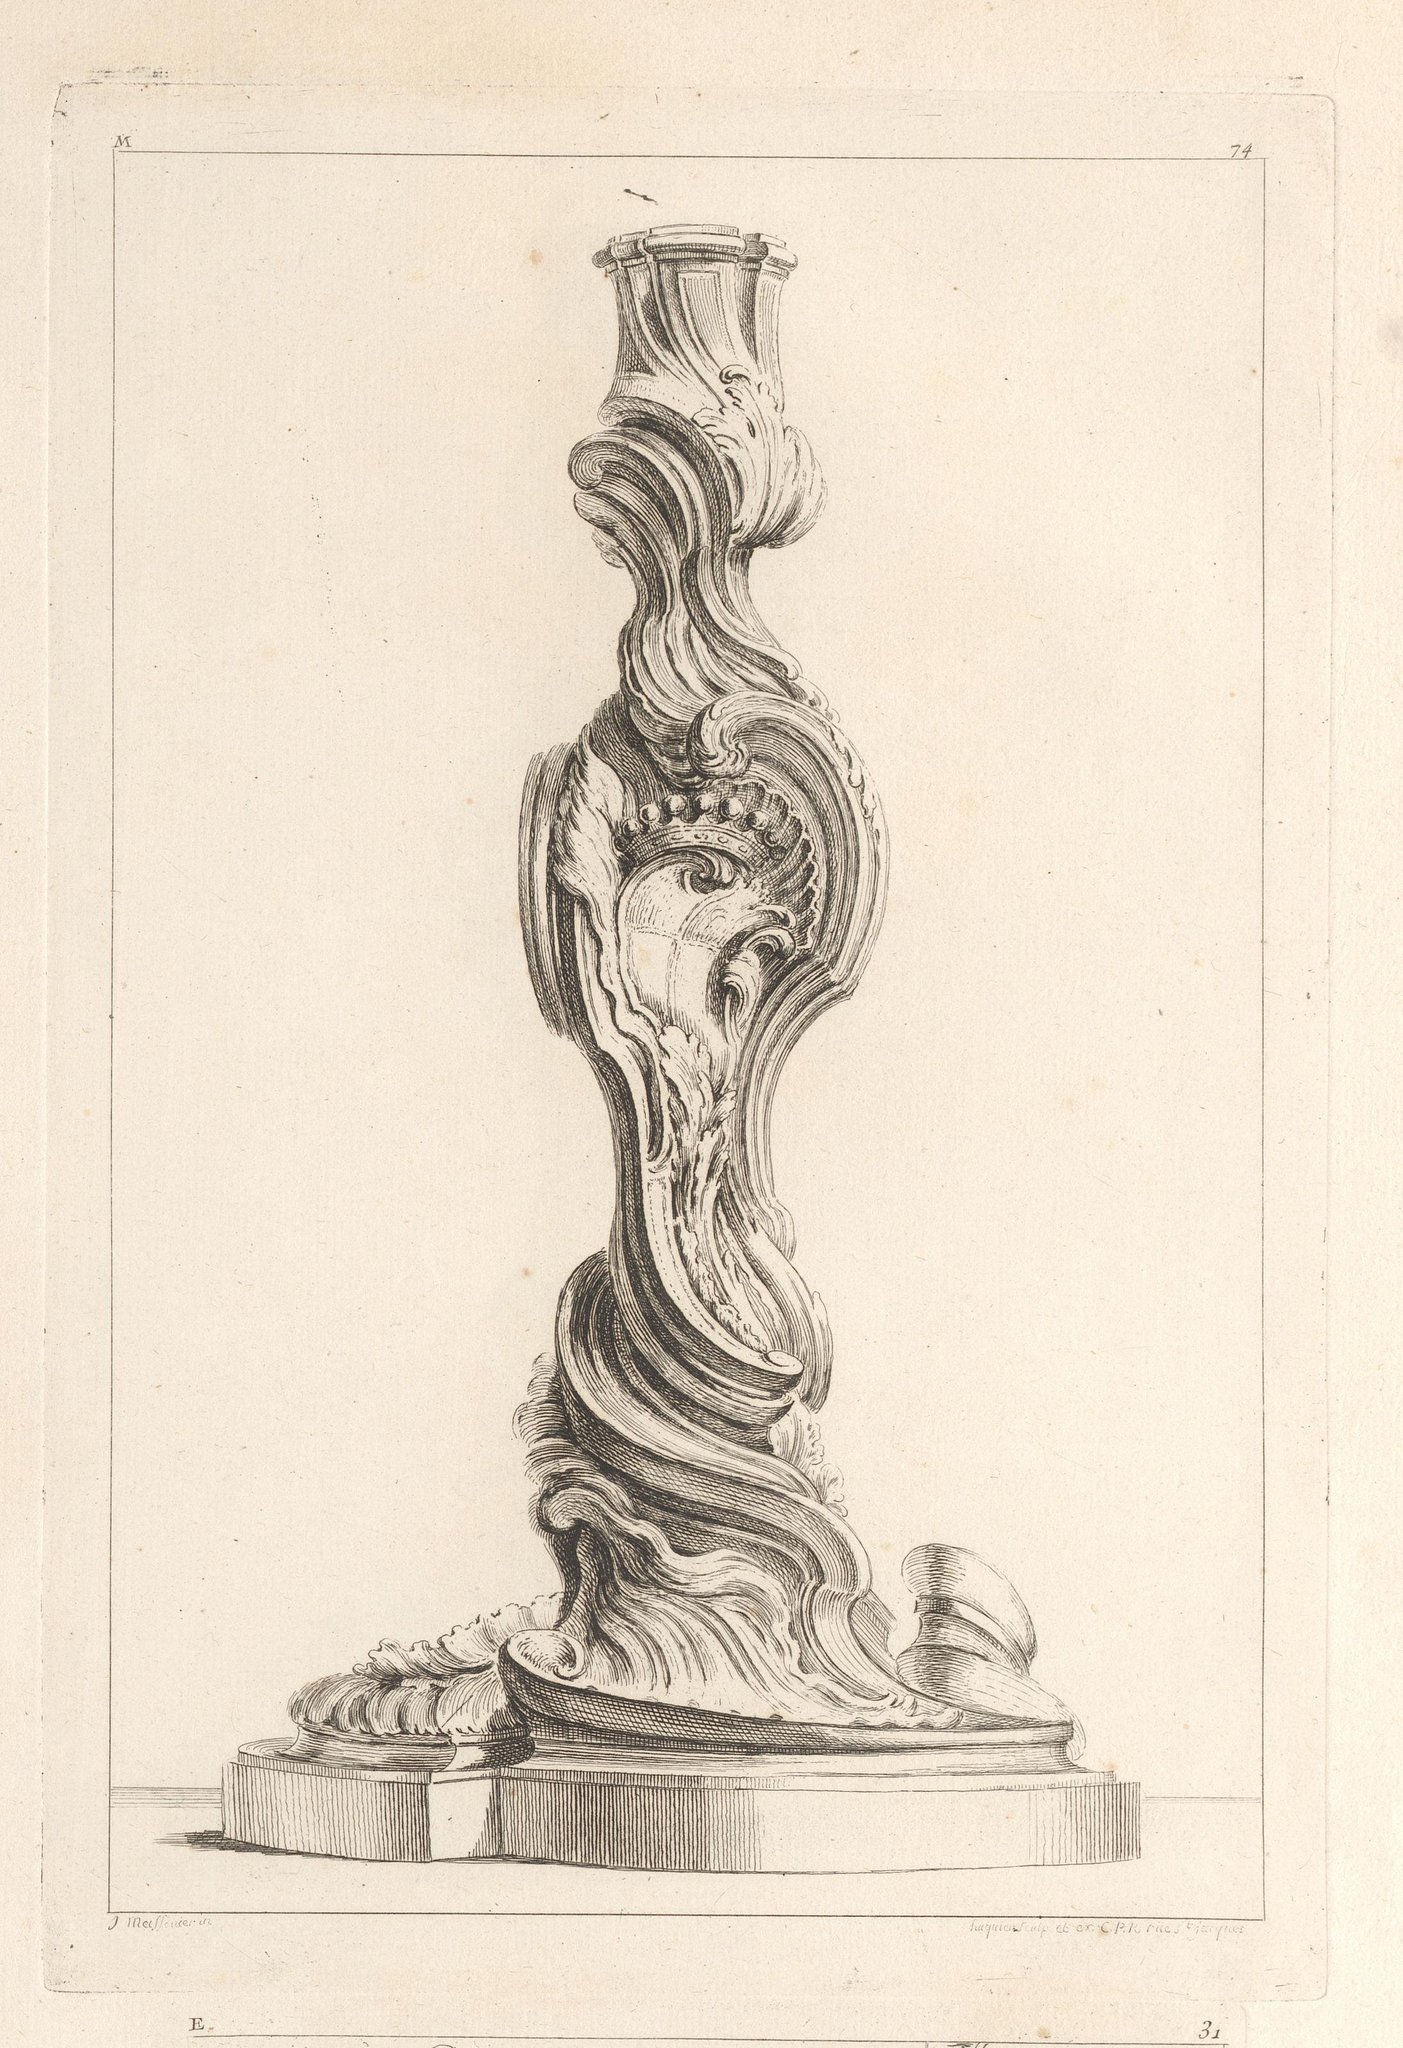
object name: print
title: Oeuvre de Juste Aurele Meissonnier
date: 1738-1749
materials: paper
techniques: etching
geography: paris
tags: work of applied art, candlestick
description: Deze prent maakt deel uit van de serie "Dousieme livre des oeuvres de J.A. Messonnier", een van de delen van de monumentale reeks "Oeuvre de Juste Aurele Meissonnier".